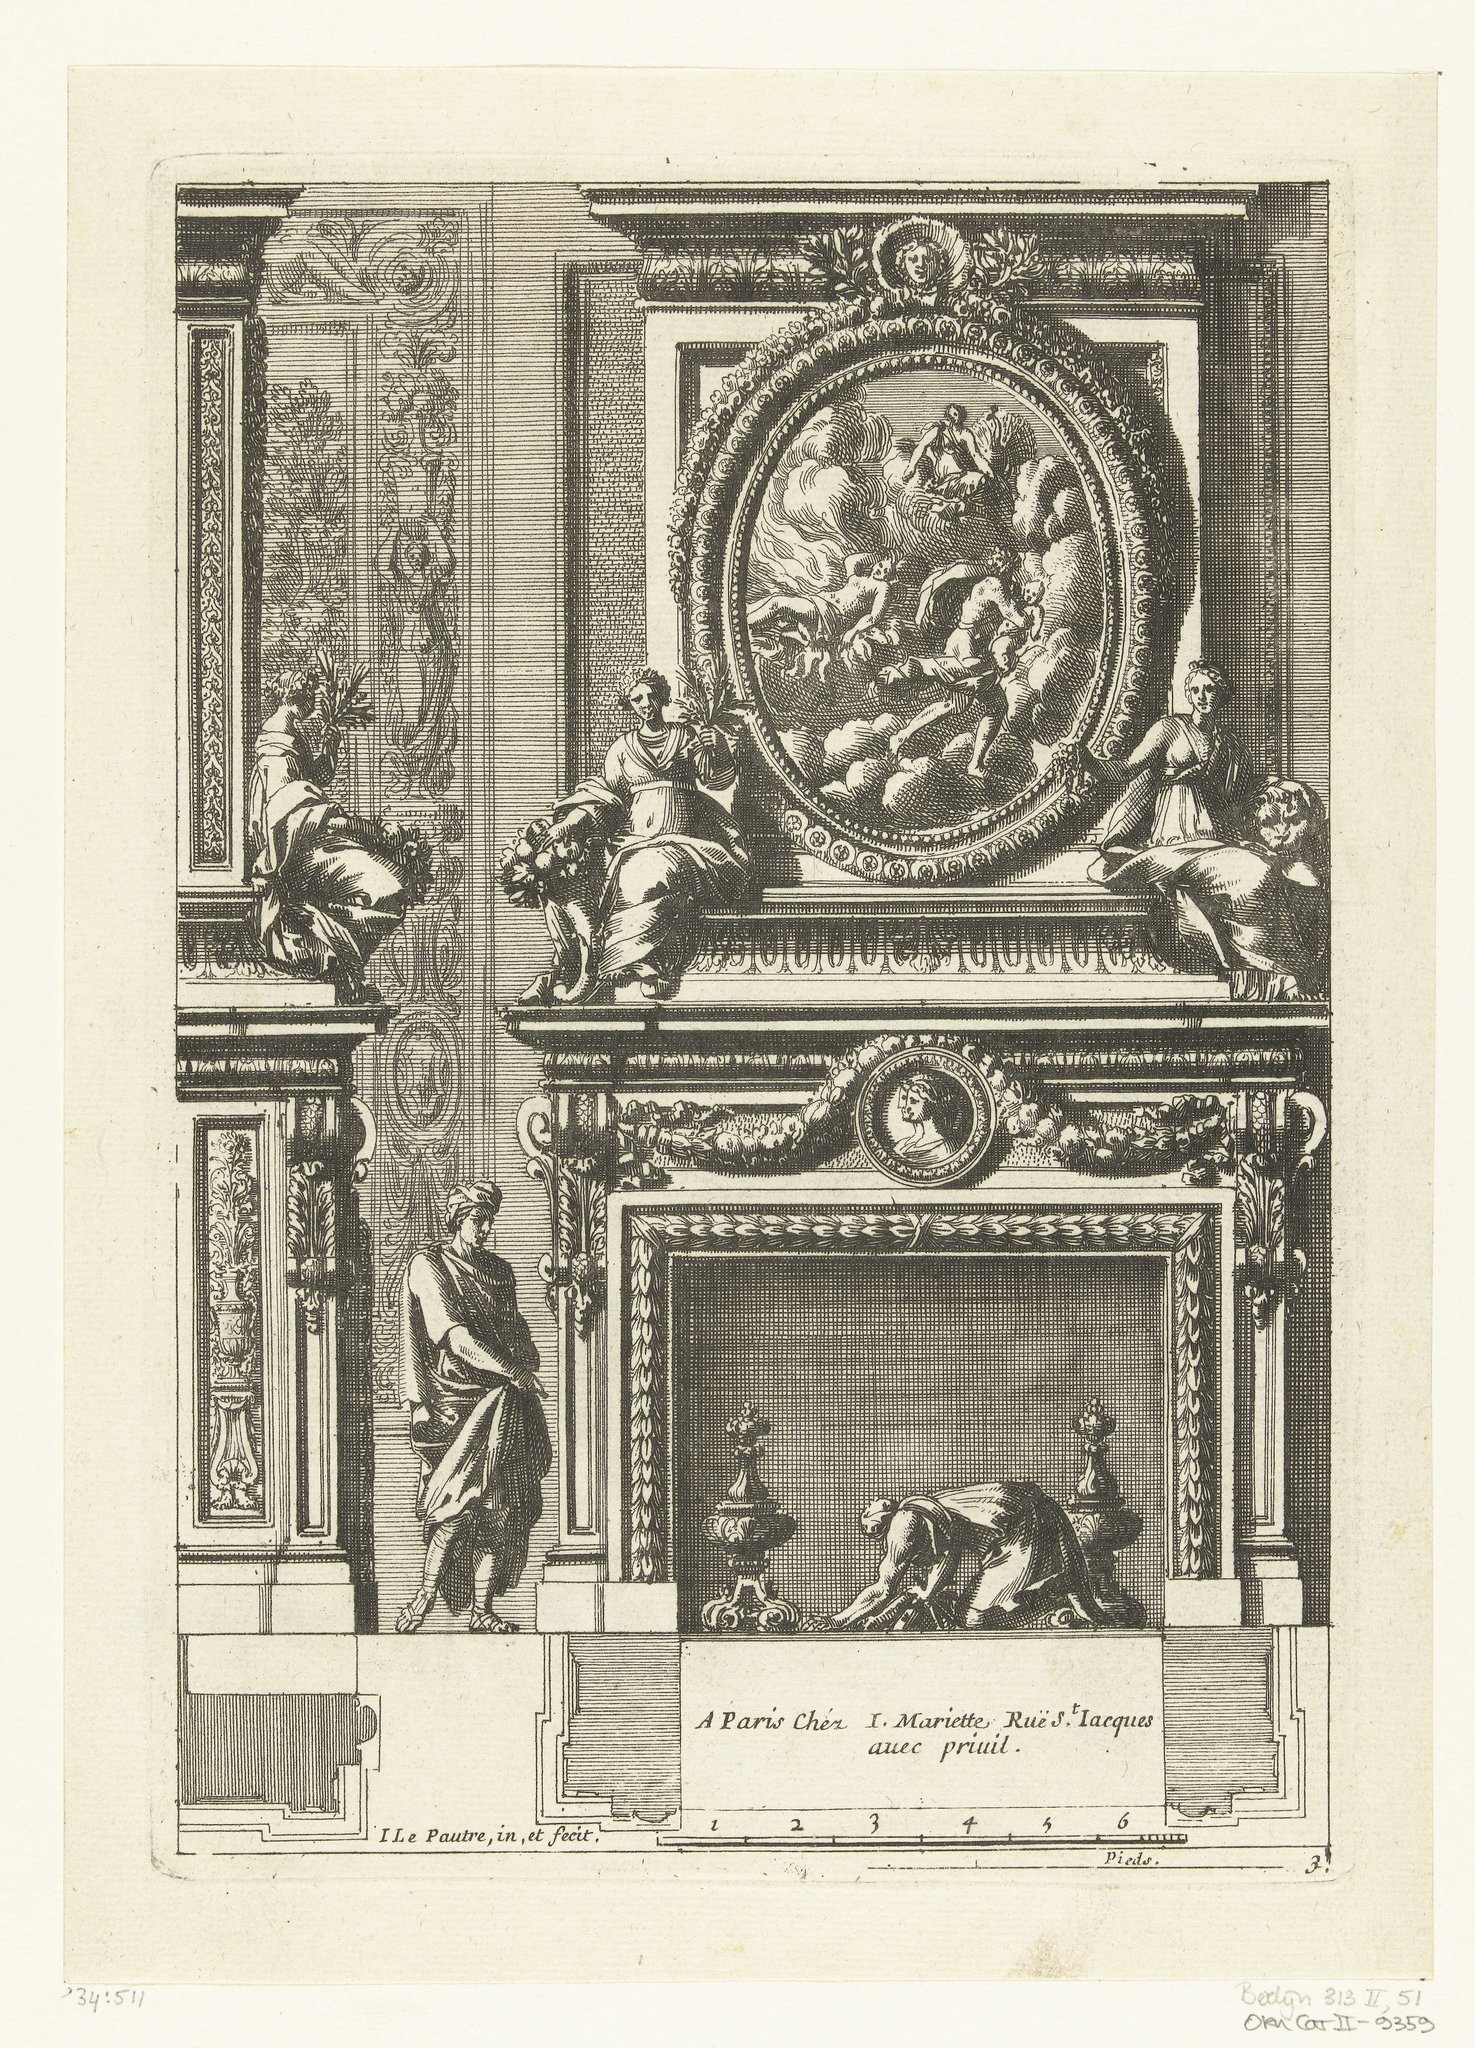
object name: print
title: Onderboezem met ovaal schilderij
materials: paper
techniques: etching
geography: france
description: Schilderij met Jupiter die Bacchus meeneemt terwijl Semele brandend sterft. Met opstand en zijopstand, beide met plannen.